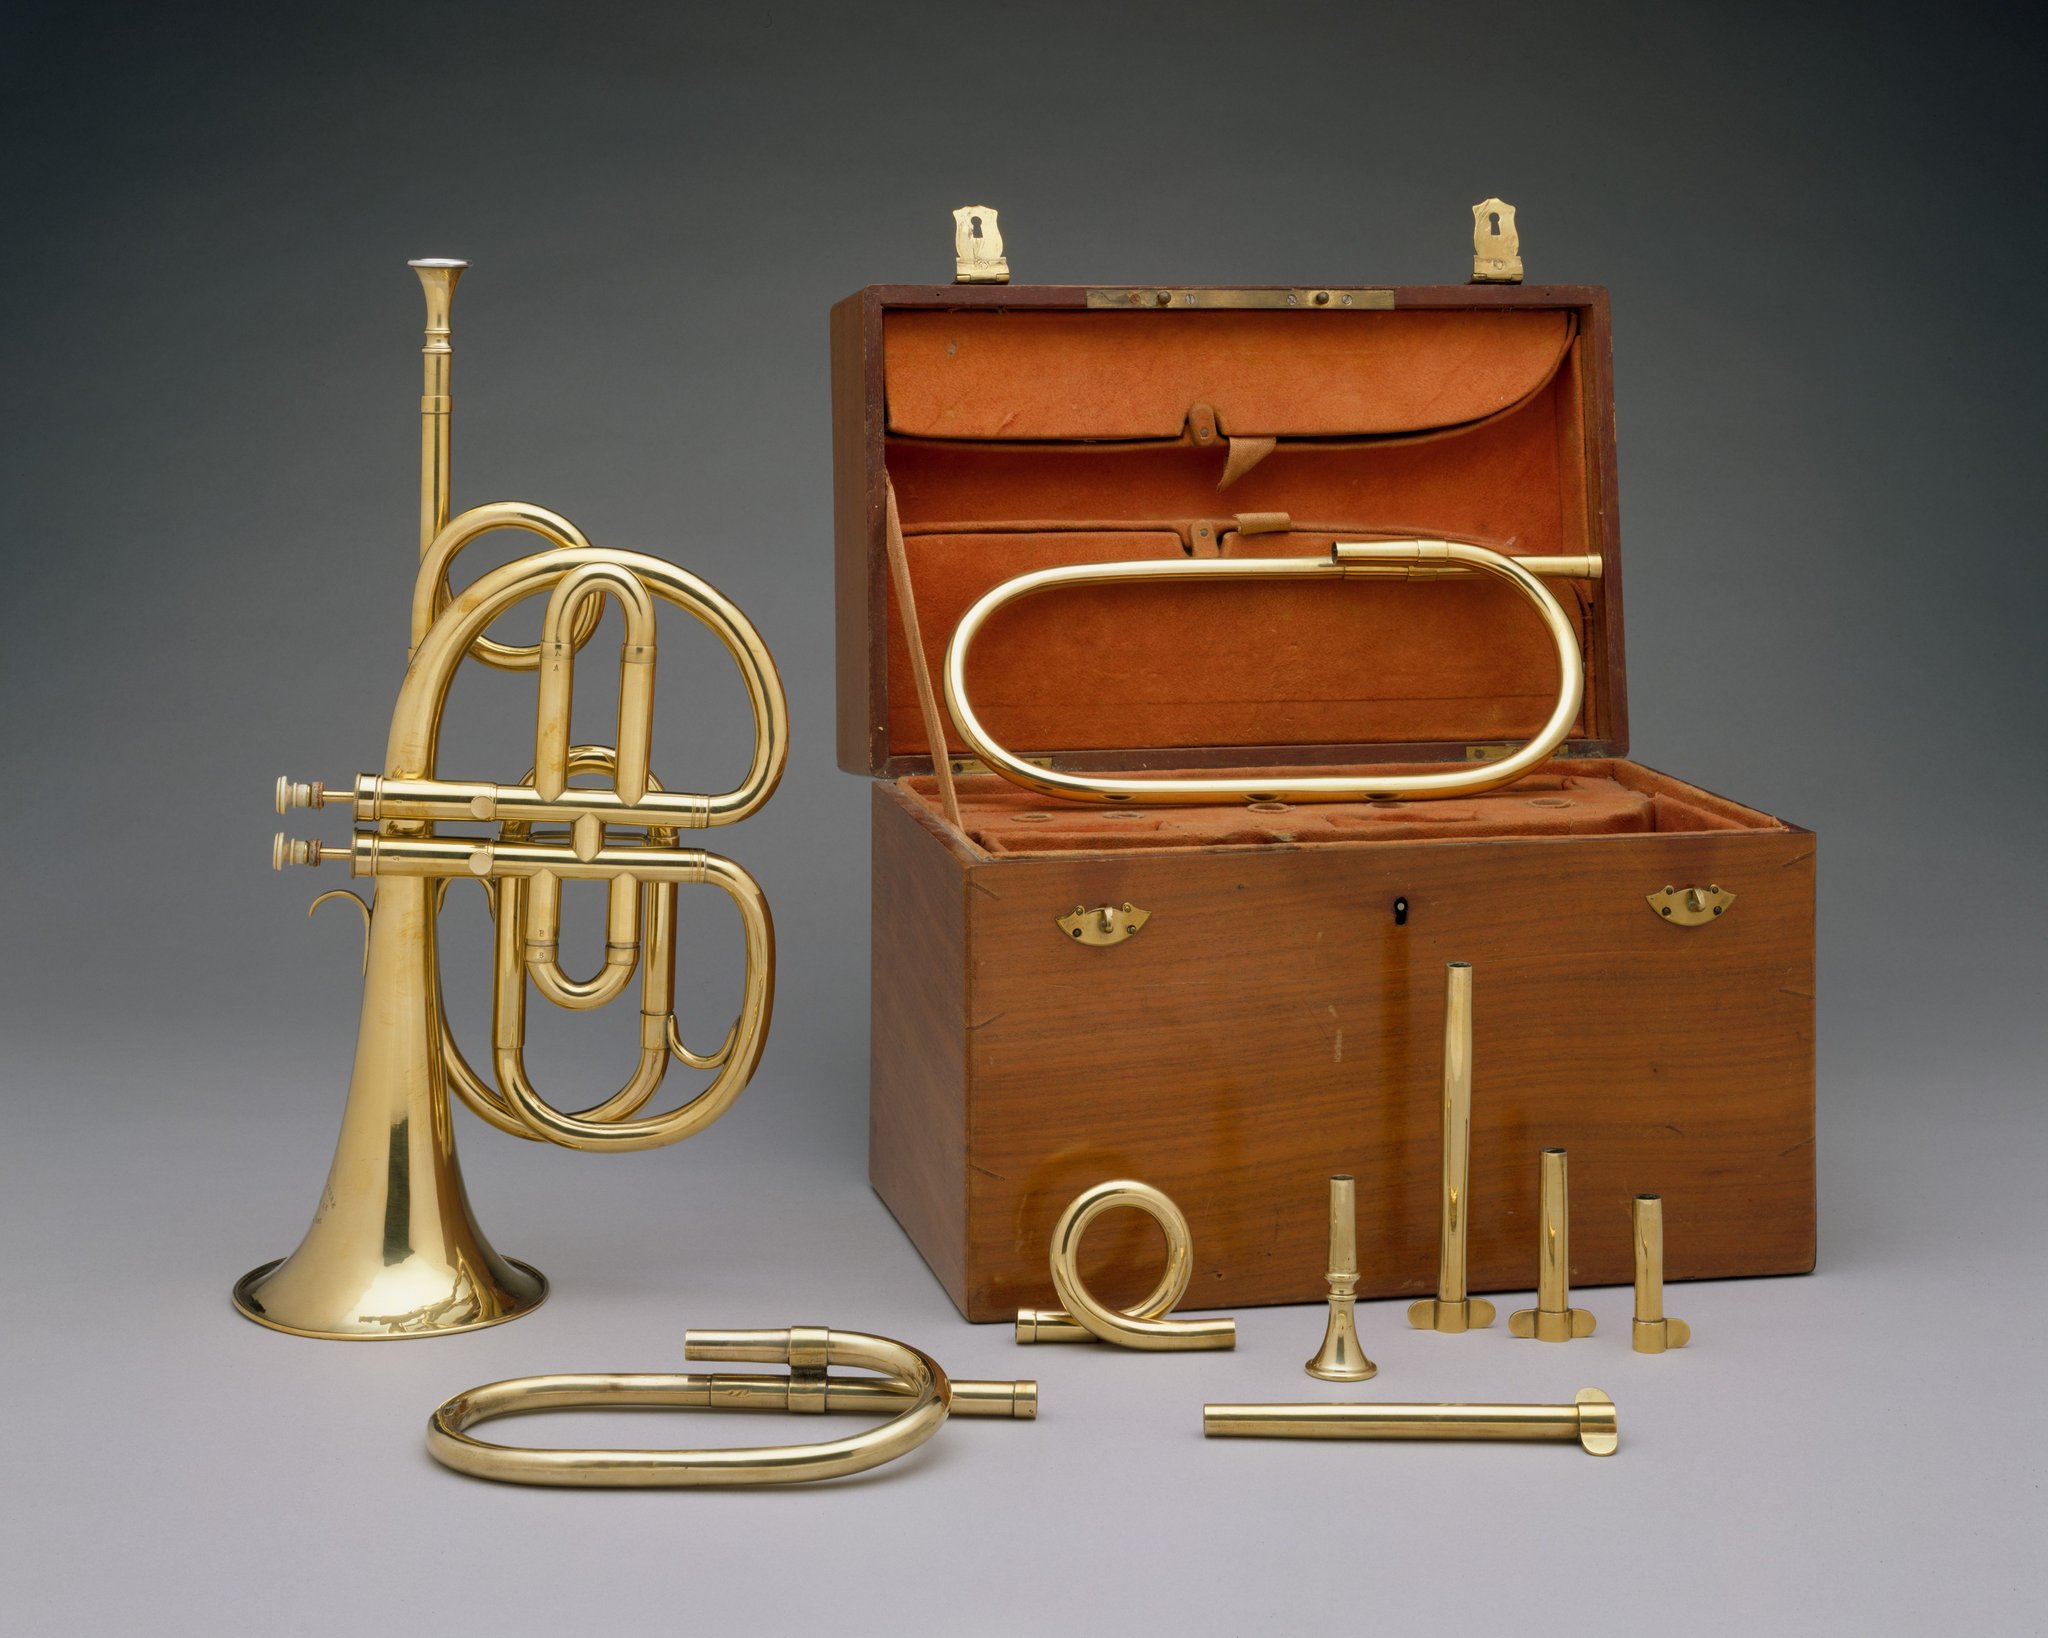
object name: cornet a piston in b flat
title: Cornet à Pistons in B-flat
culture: french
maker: courtois frères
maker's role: maker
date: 1833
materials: brass, ivory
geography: france